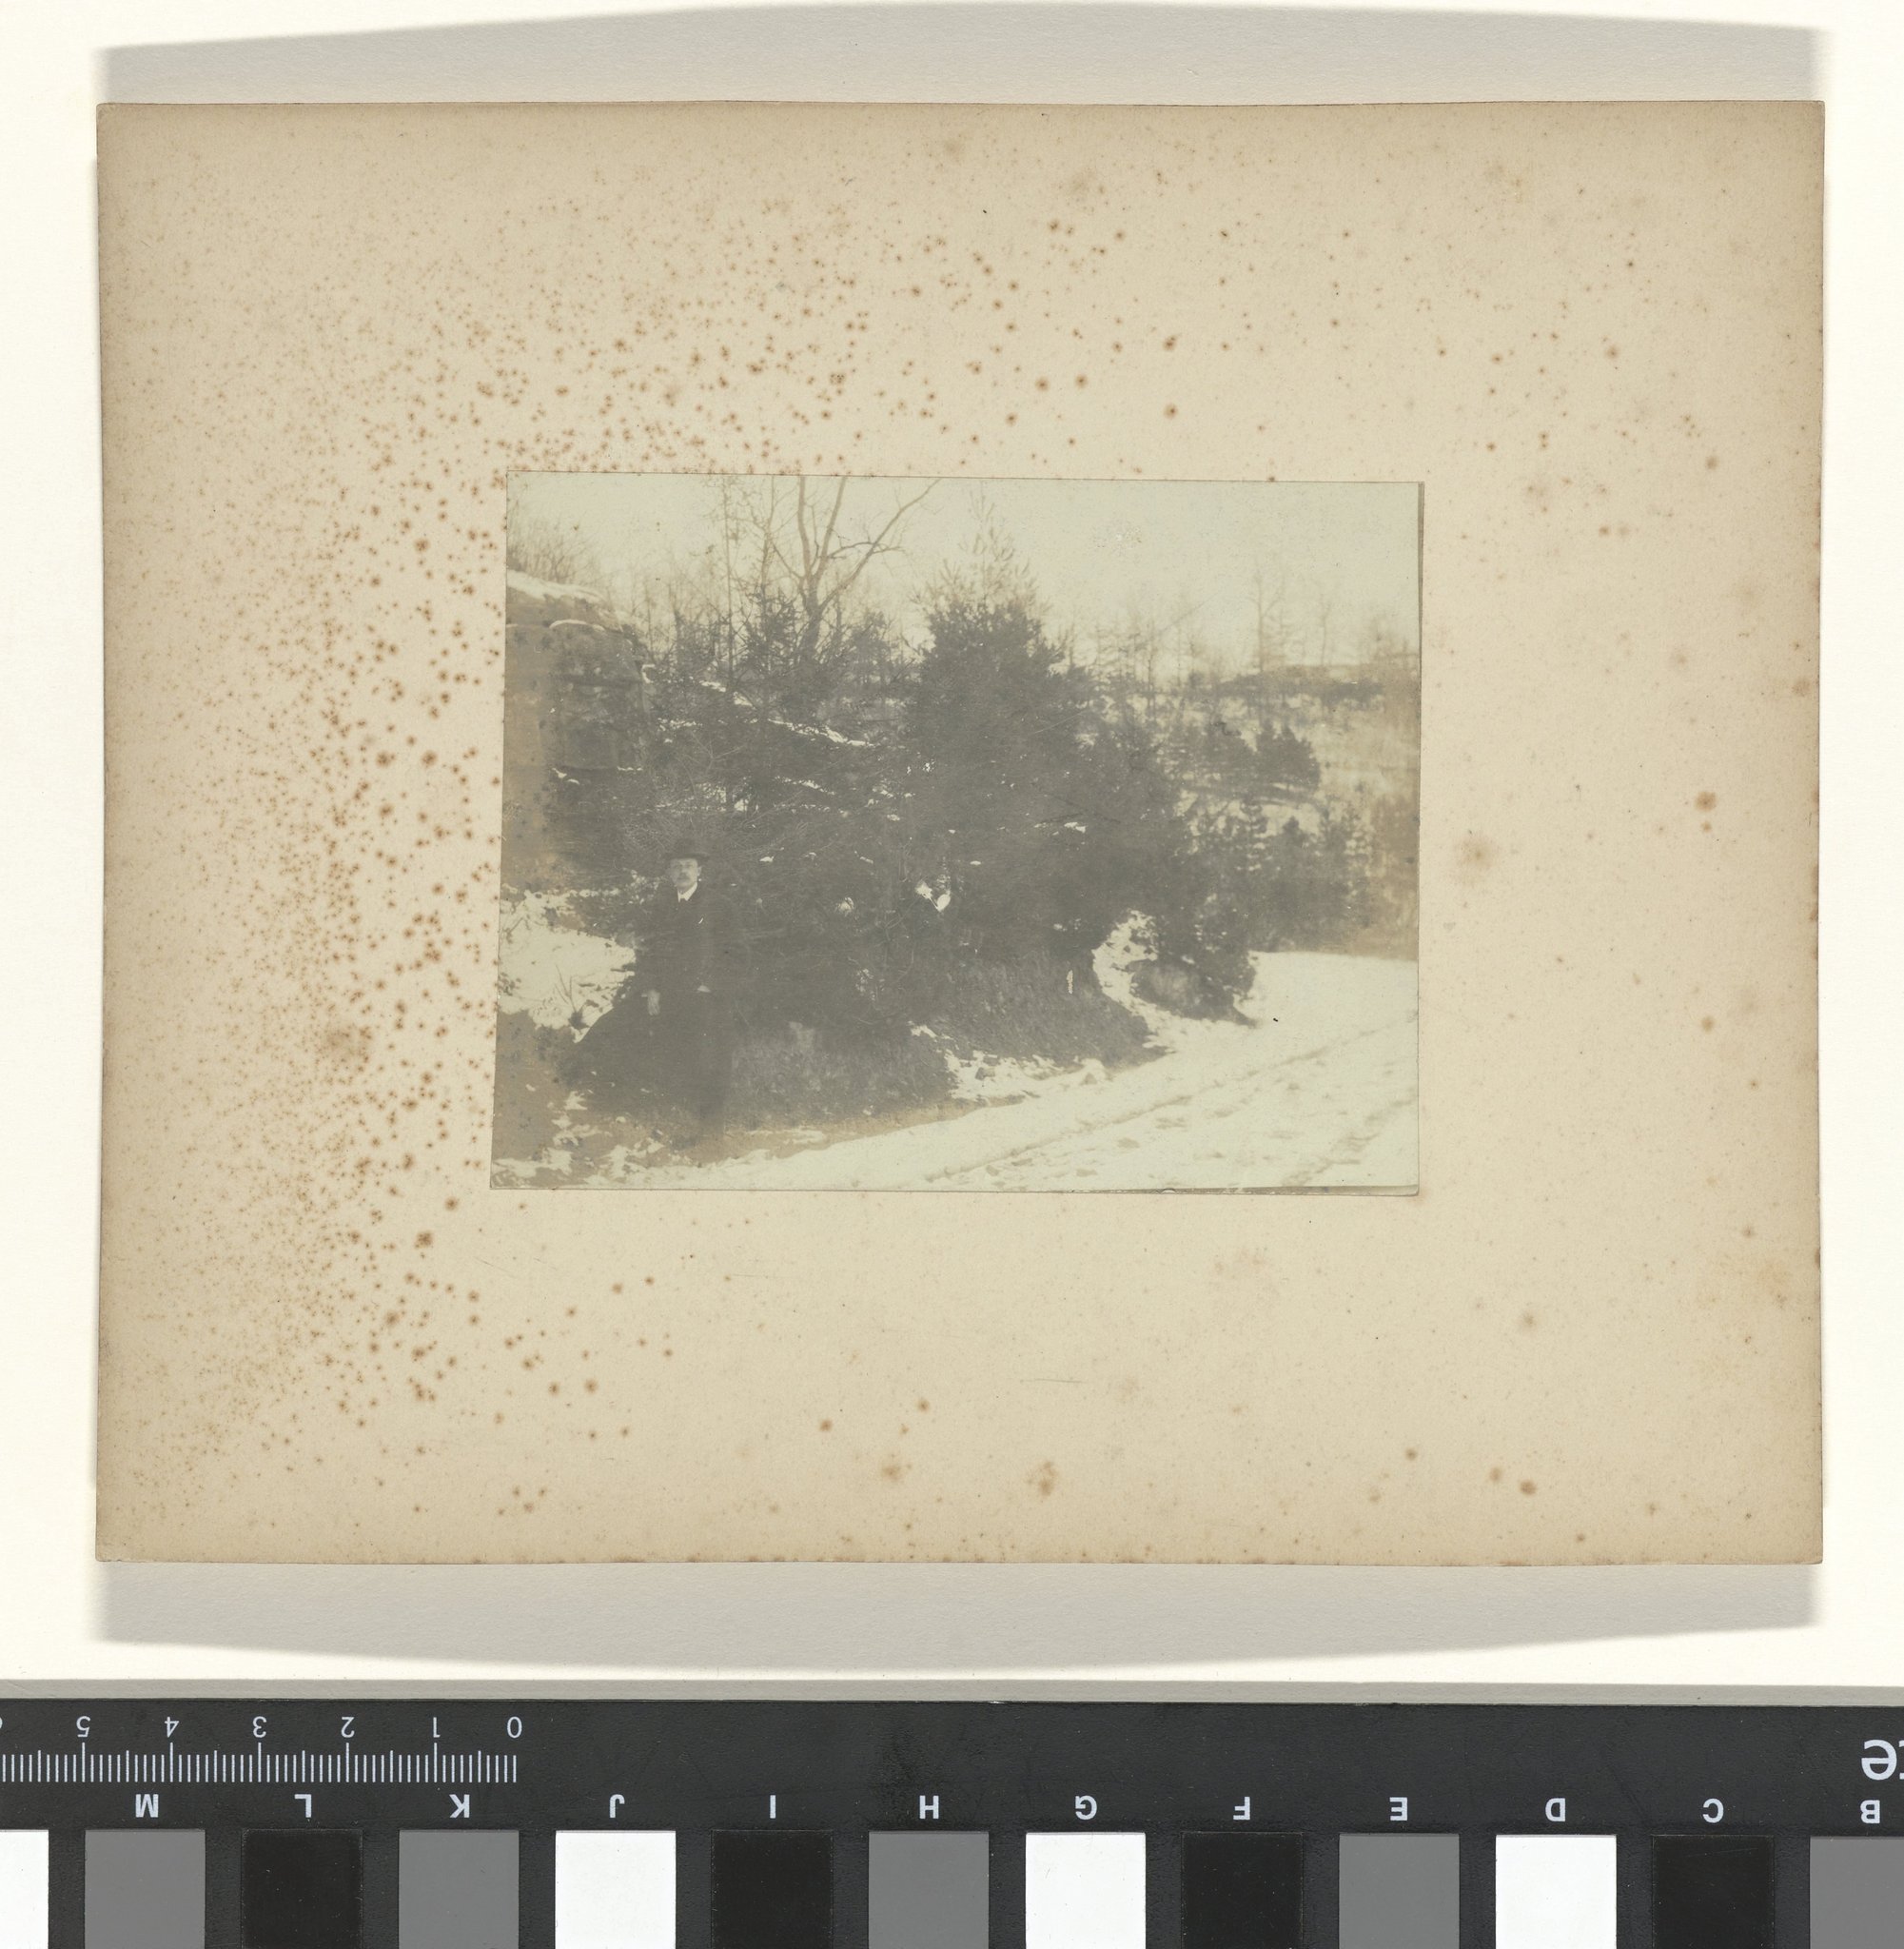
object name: photograph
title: Jan C. Schüller in de Meramec Highlands tijdens de wereldtentoonstelling in St. Louis (Louisiana Purchase Exposition), 1904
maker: Anonymous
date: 1904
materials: cardboard, paper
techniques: gelatin silver print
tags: jan schüller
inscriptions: annotation: ‘Jan C. Schüller’, annotation: ‘Een der hoogste plekjes van // Meramec Highland’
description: Jan C. Schüller in de Meramec Highlands tijdens de wereldtentoonstelling in St. Louis (Louisiana Purchase Exposition), 1904.